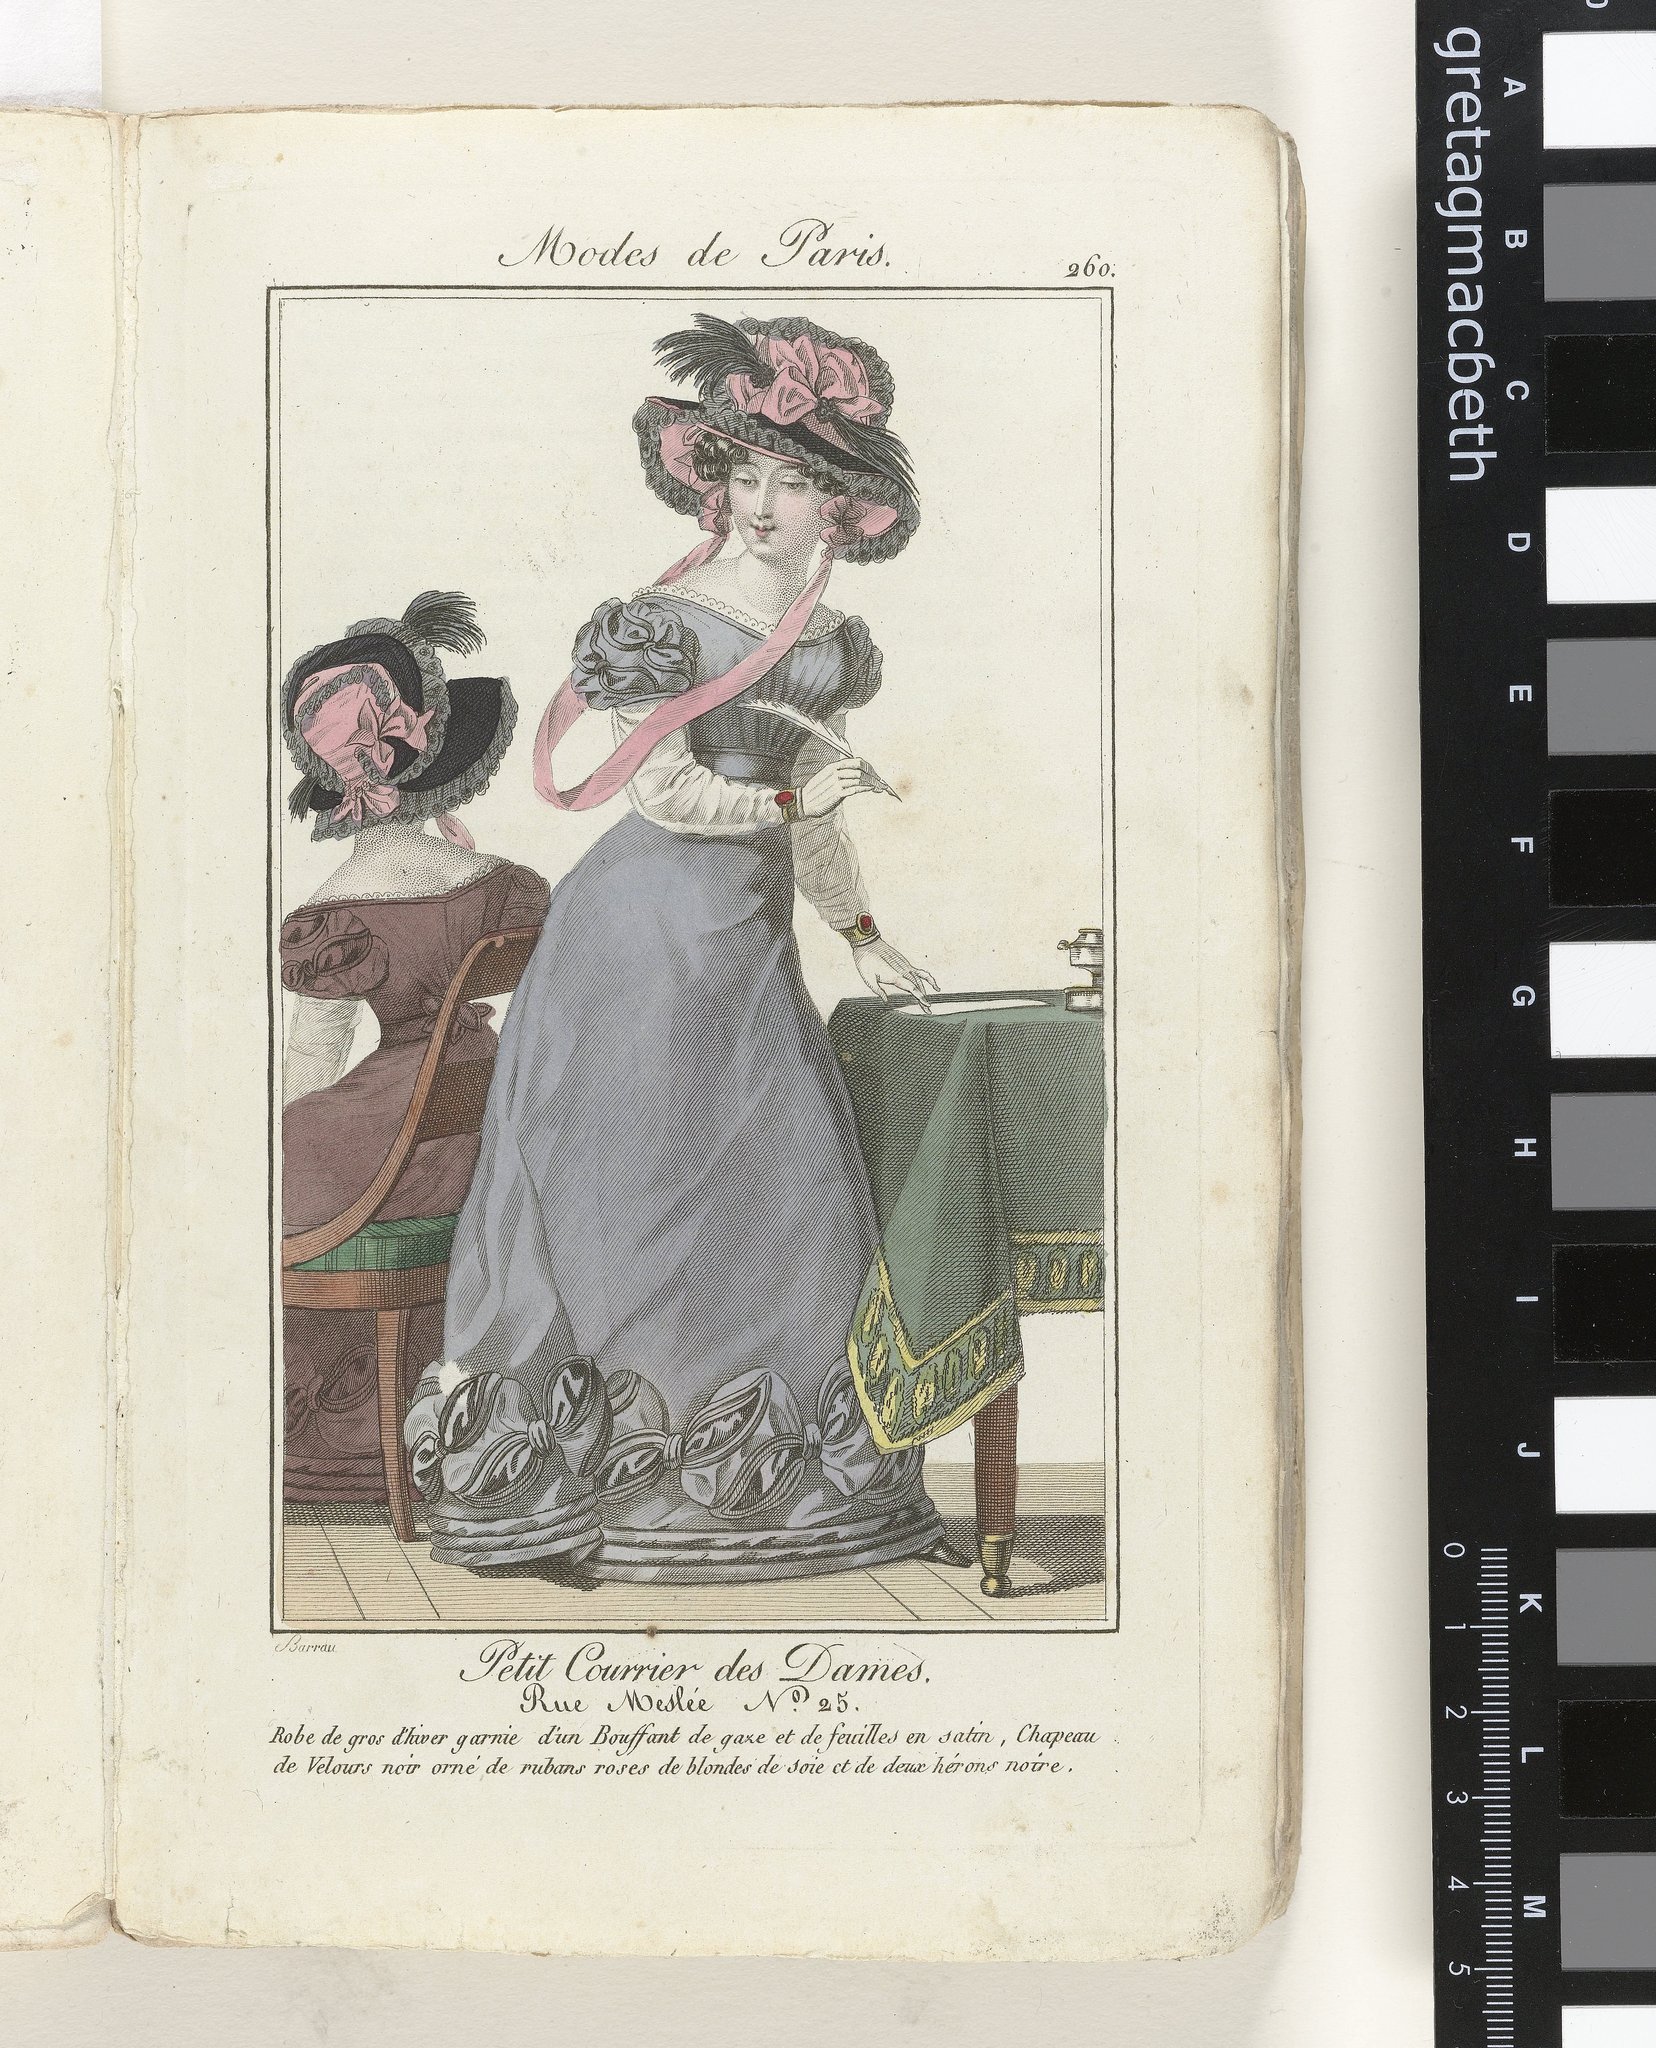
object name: fashion print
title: Petit Courrier des Dames 1824 (260)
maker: barrau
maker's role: print maker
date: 1824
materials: paper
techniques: engraving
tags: fashion plates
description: Prent uit het modetijdschrift Petit Courrier des Dames (1821-1868).